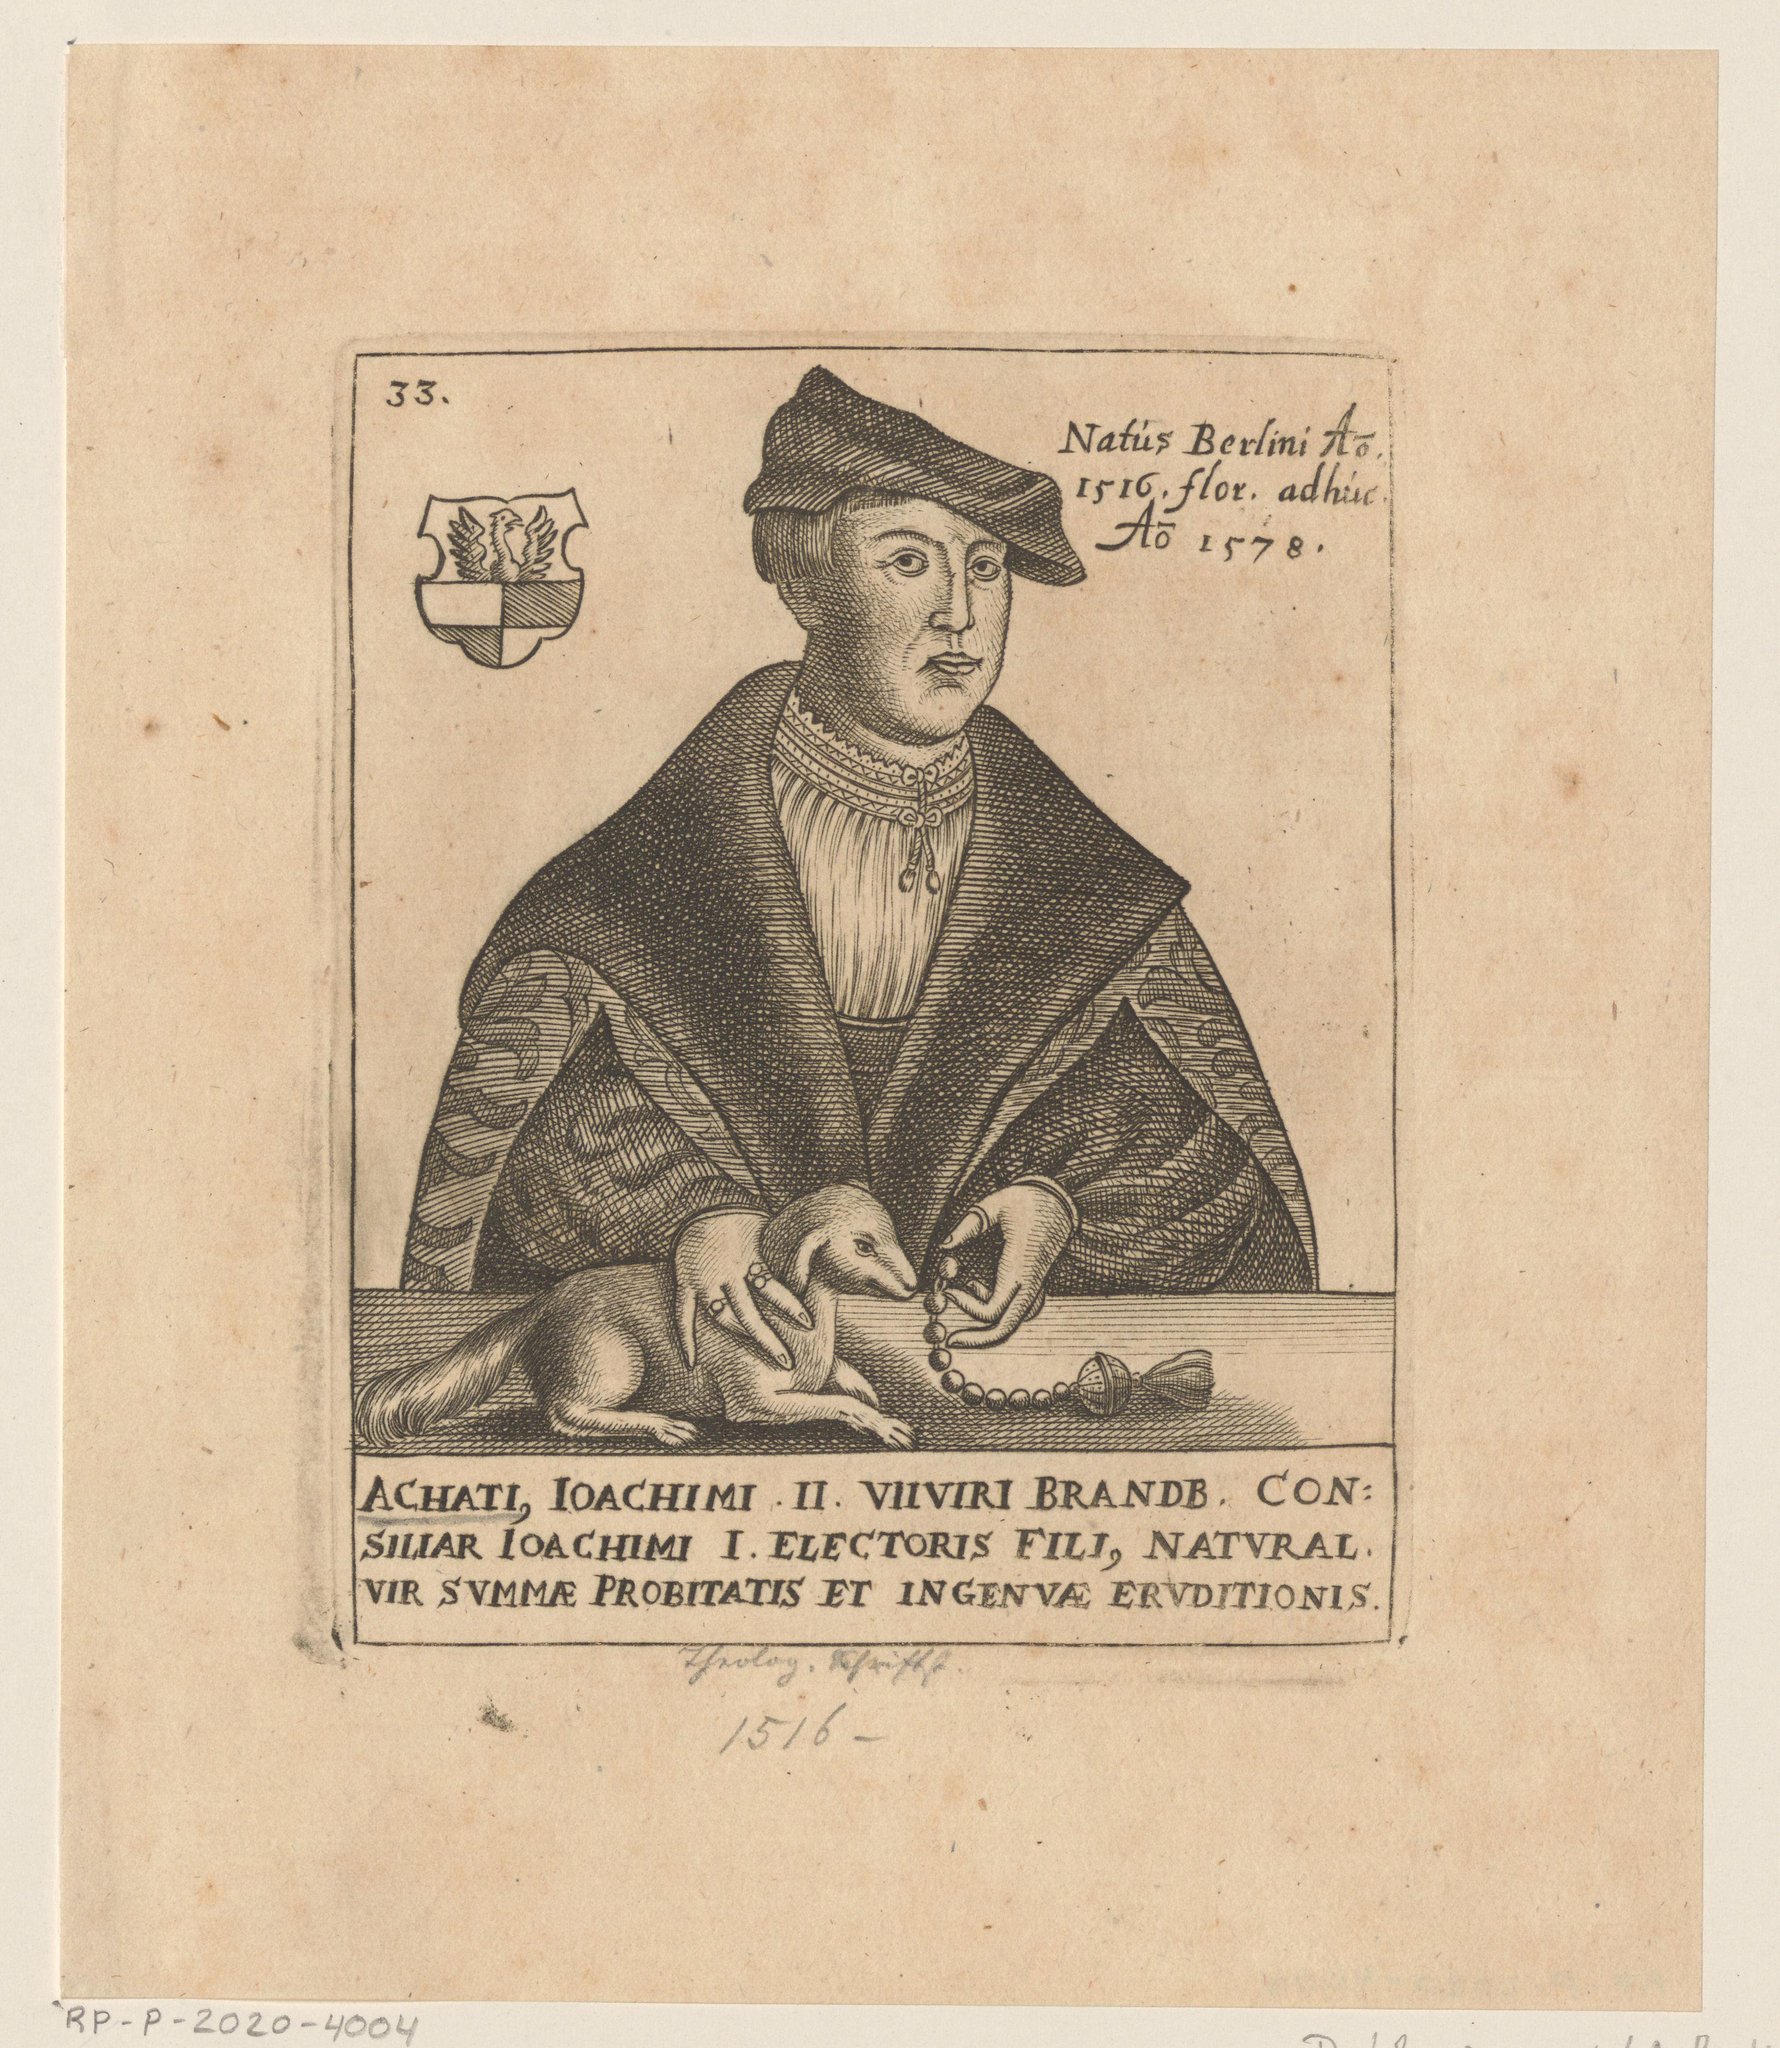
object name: book illustration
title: Portret van Achatius von Brandenburg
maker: Anonymous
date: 1671-1751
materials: paper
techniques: engraving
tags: historical persons, armorial bearing, heraldry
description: De prent is uitgegeven als onderdeel van een serie. Later is de prent mogelijk ook als boekillustratie gebruikt in: Küster, Georg Gottfried. Martin Friedrich Seidels Bilder-Sammlung in welcher hundert, gröstentheils in der Mark Brandenburg (…). Berlijn: Buchladen bey der Real-Schule, 1751. Het is onduidelijk tot welke uitgave de huidige prent behoort.